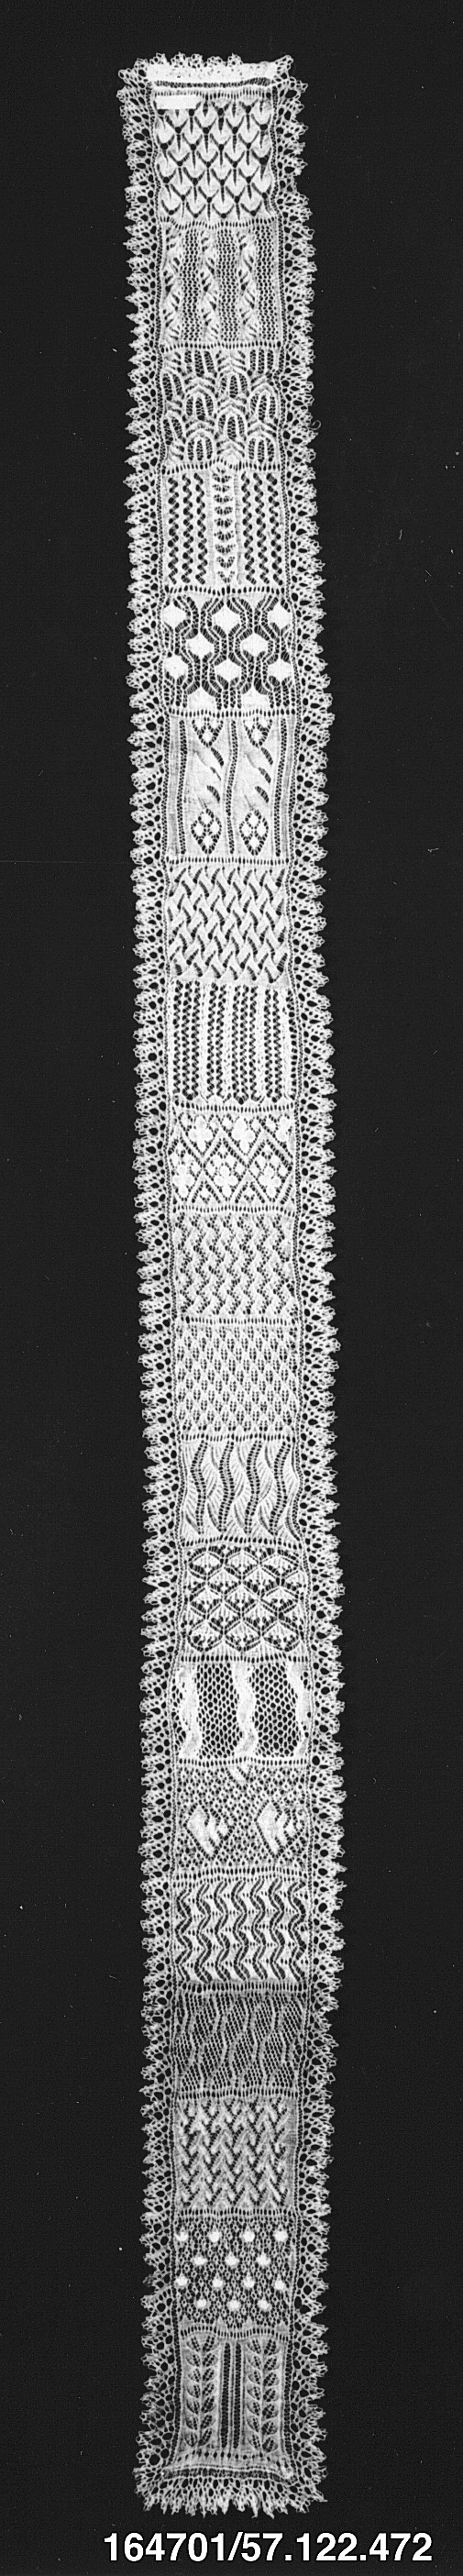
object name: sampler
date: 1801-1900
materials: cotton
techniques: embroidery